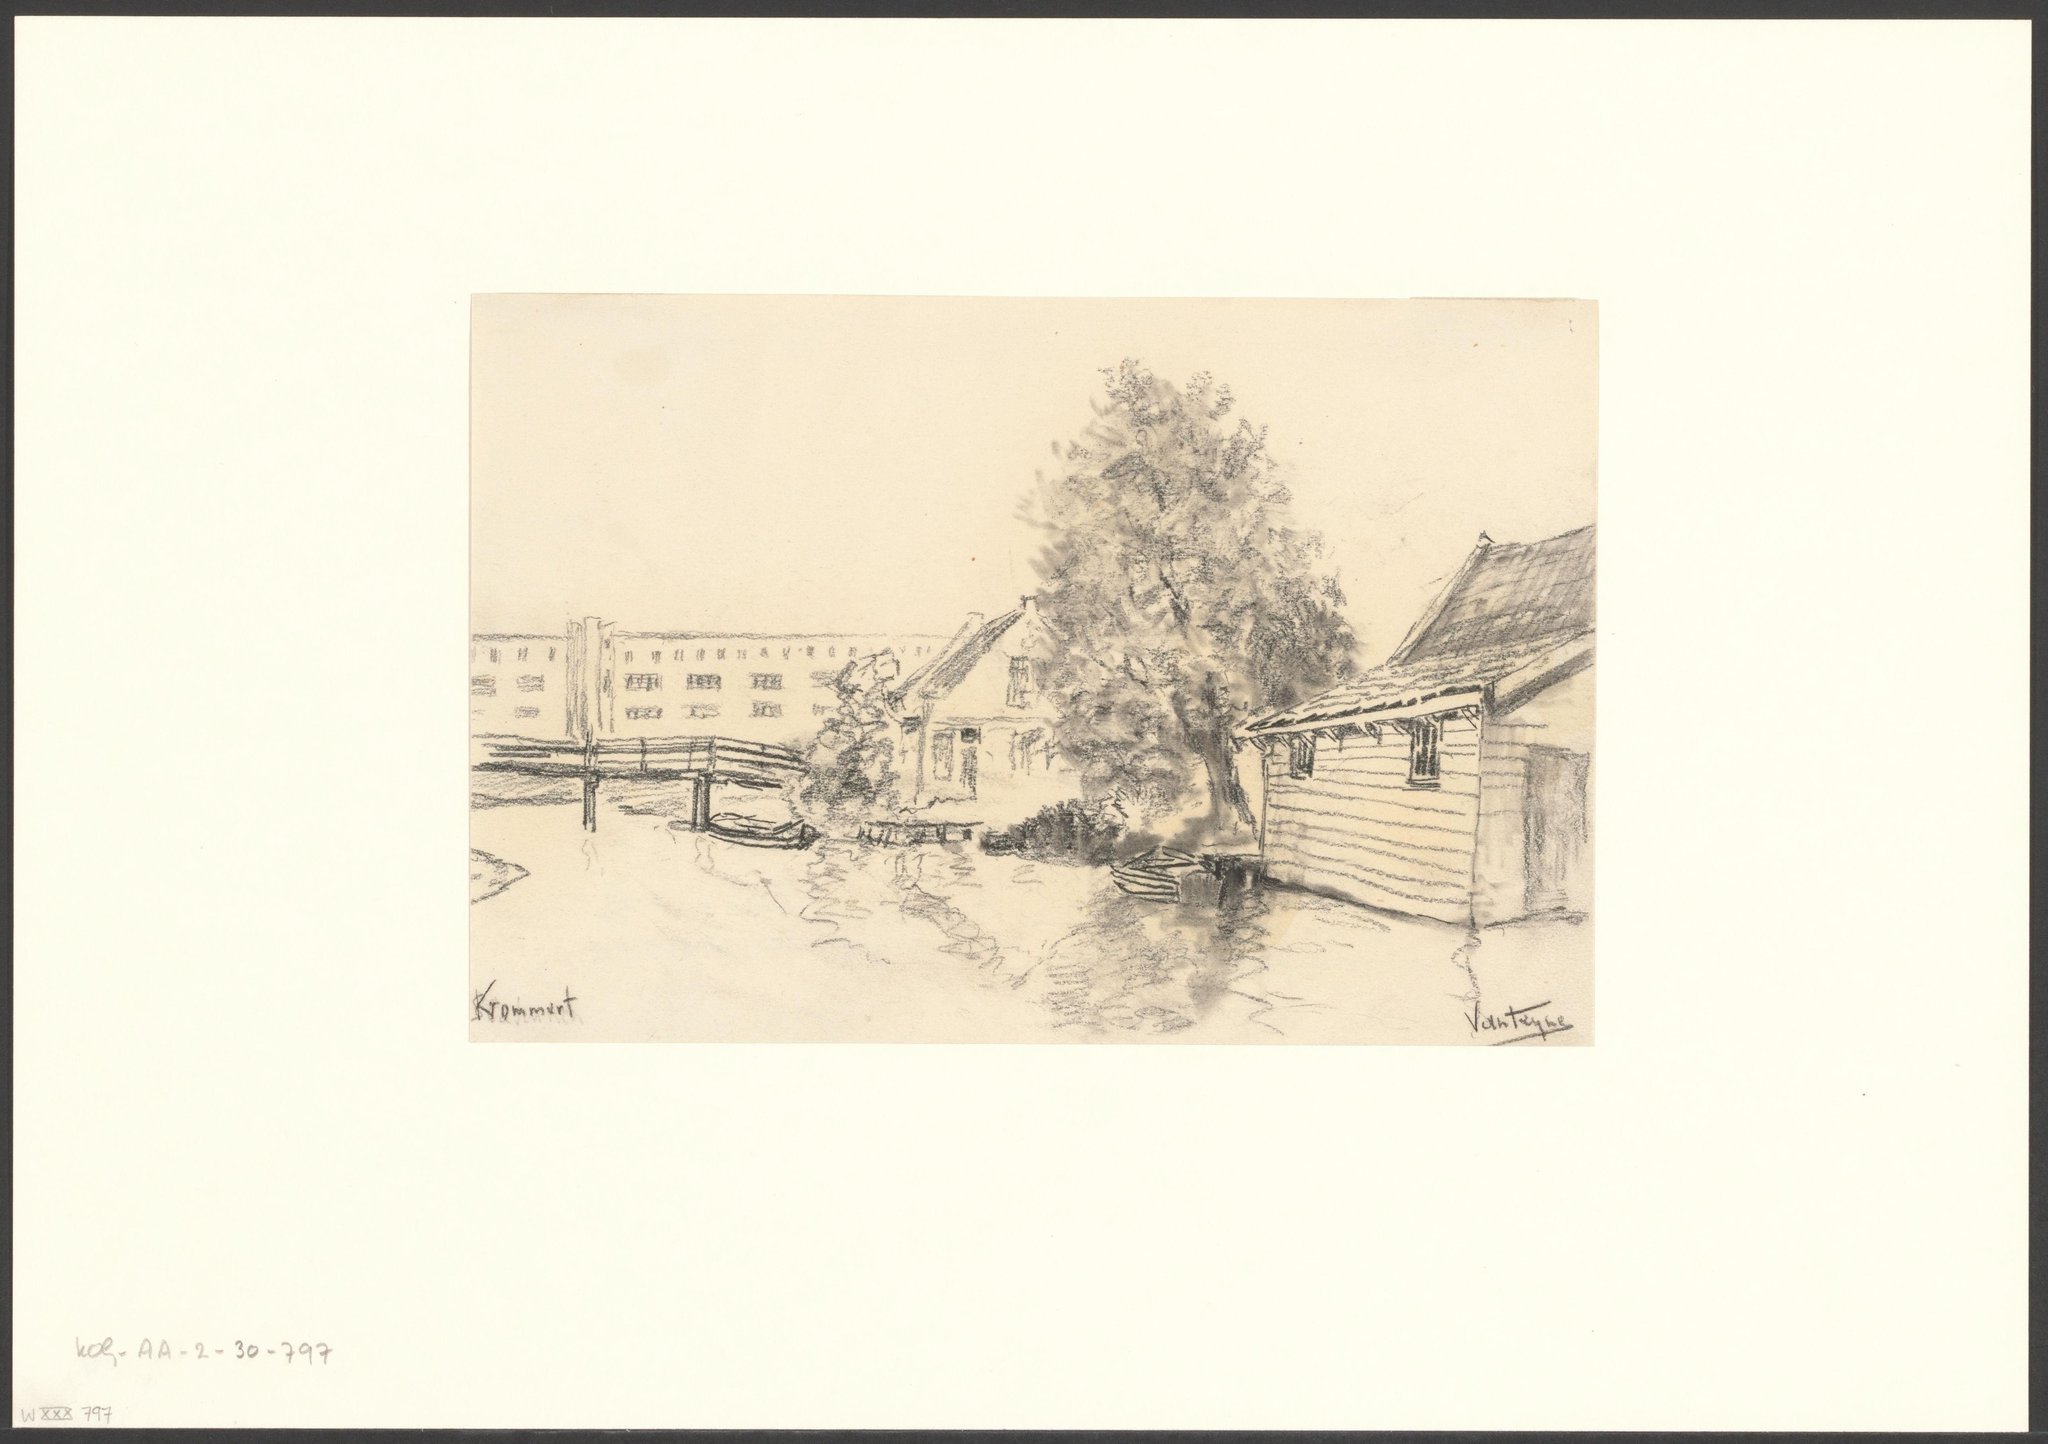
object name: drawing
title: Gezicht op De Krommert vanaf de Admiraal de Ruijterweg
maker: anthonie van teijn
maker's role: draughtsman, painter, print maker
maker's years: 1863-1943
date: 1907-1927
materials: chalk, paper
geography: amsterdam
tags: city-view in general; 'veduta', detached house in city, canal, the usual house or row of houses, boat propelled by man or animal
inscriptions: inscription: ‘De Krommert gezien (...) Juli 1927 / vanEck’, signature: ‘VanTeyne’, collector's mark: Lugt 800a, inscription: ‘Krommert’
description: Tekening binnen de Atlas Van Eck ingedeeld op wijknummer 30.